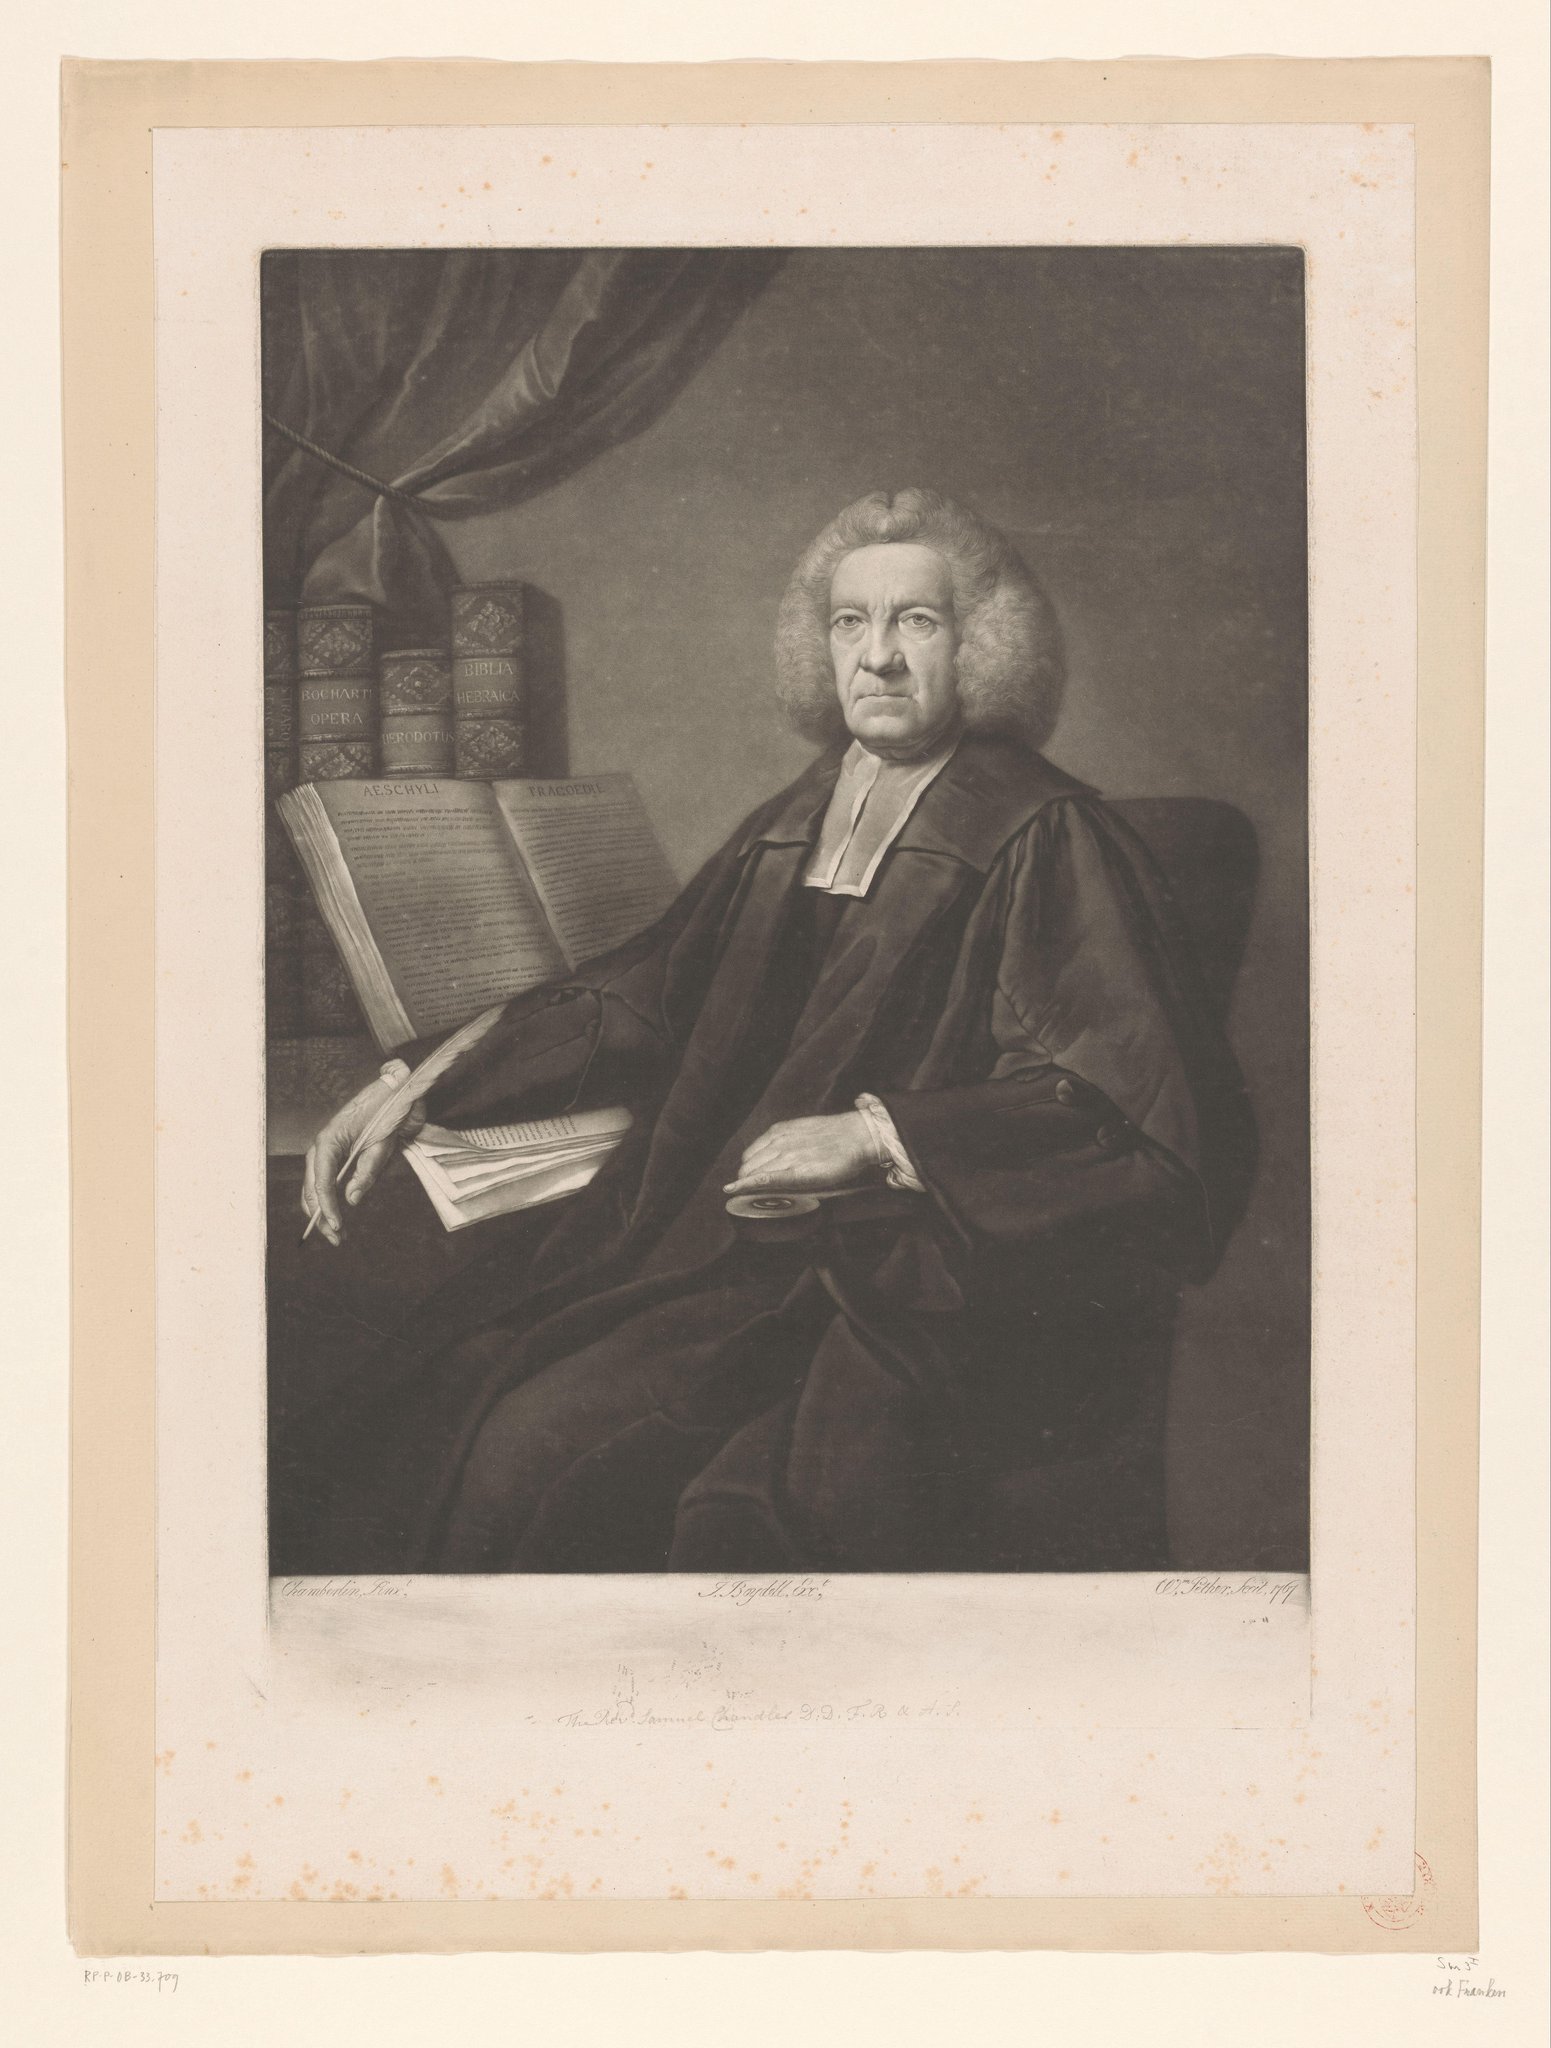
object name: print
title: Portret van Samuel Chandler aan een schrijftafel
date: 1767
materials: paper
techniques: etching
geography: london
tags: london, writing-table, writing-desk, historical persons, book, politician, e.g. party leader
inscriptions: : ‘The Revd. Samuel Chandler D.D. F.R. & A.S.’, collector's mark: Lugt 240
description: Op zijn tafel staan de boeken met op de rug 'Strabo', 'Bocharti Opera', 'Herodutus', 'Biblia Hebraica'. Voor Samuel Chandler ligt een geopend boek met tragediën geschreven door de Griekse dichter Aeschylus.